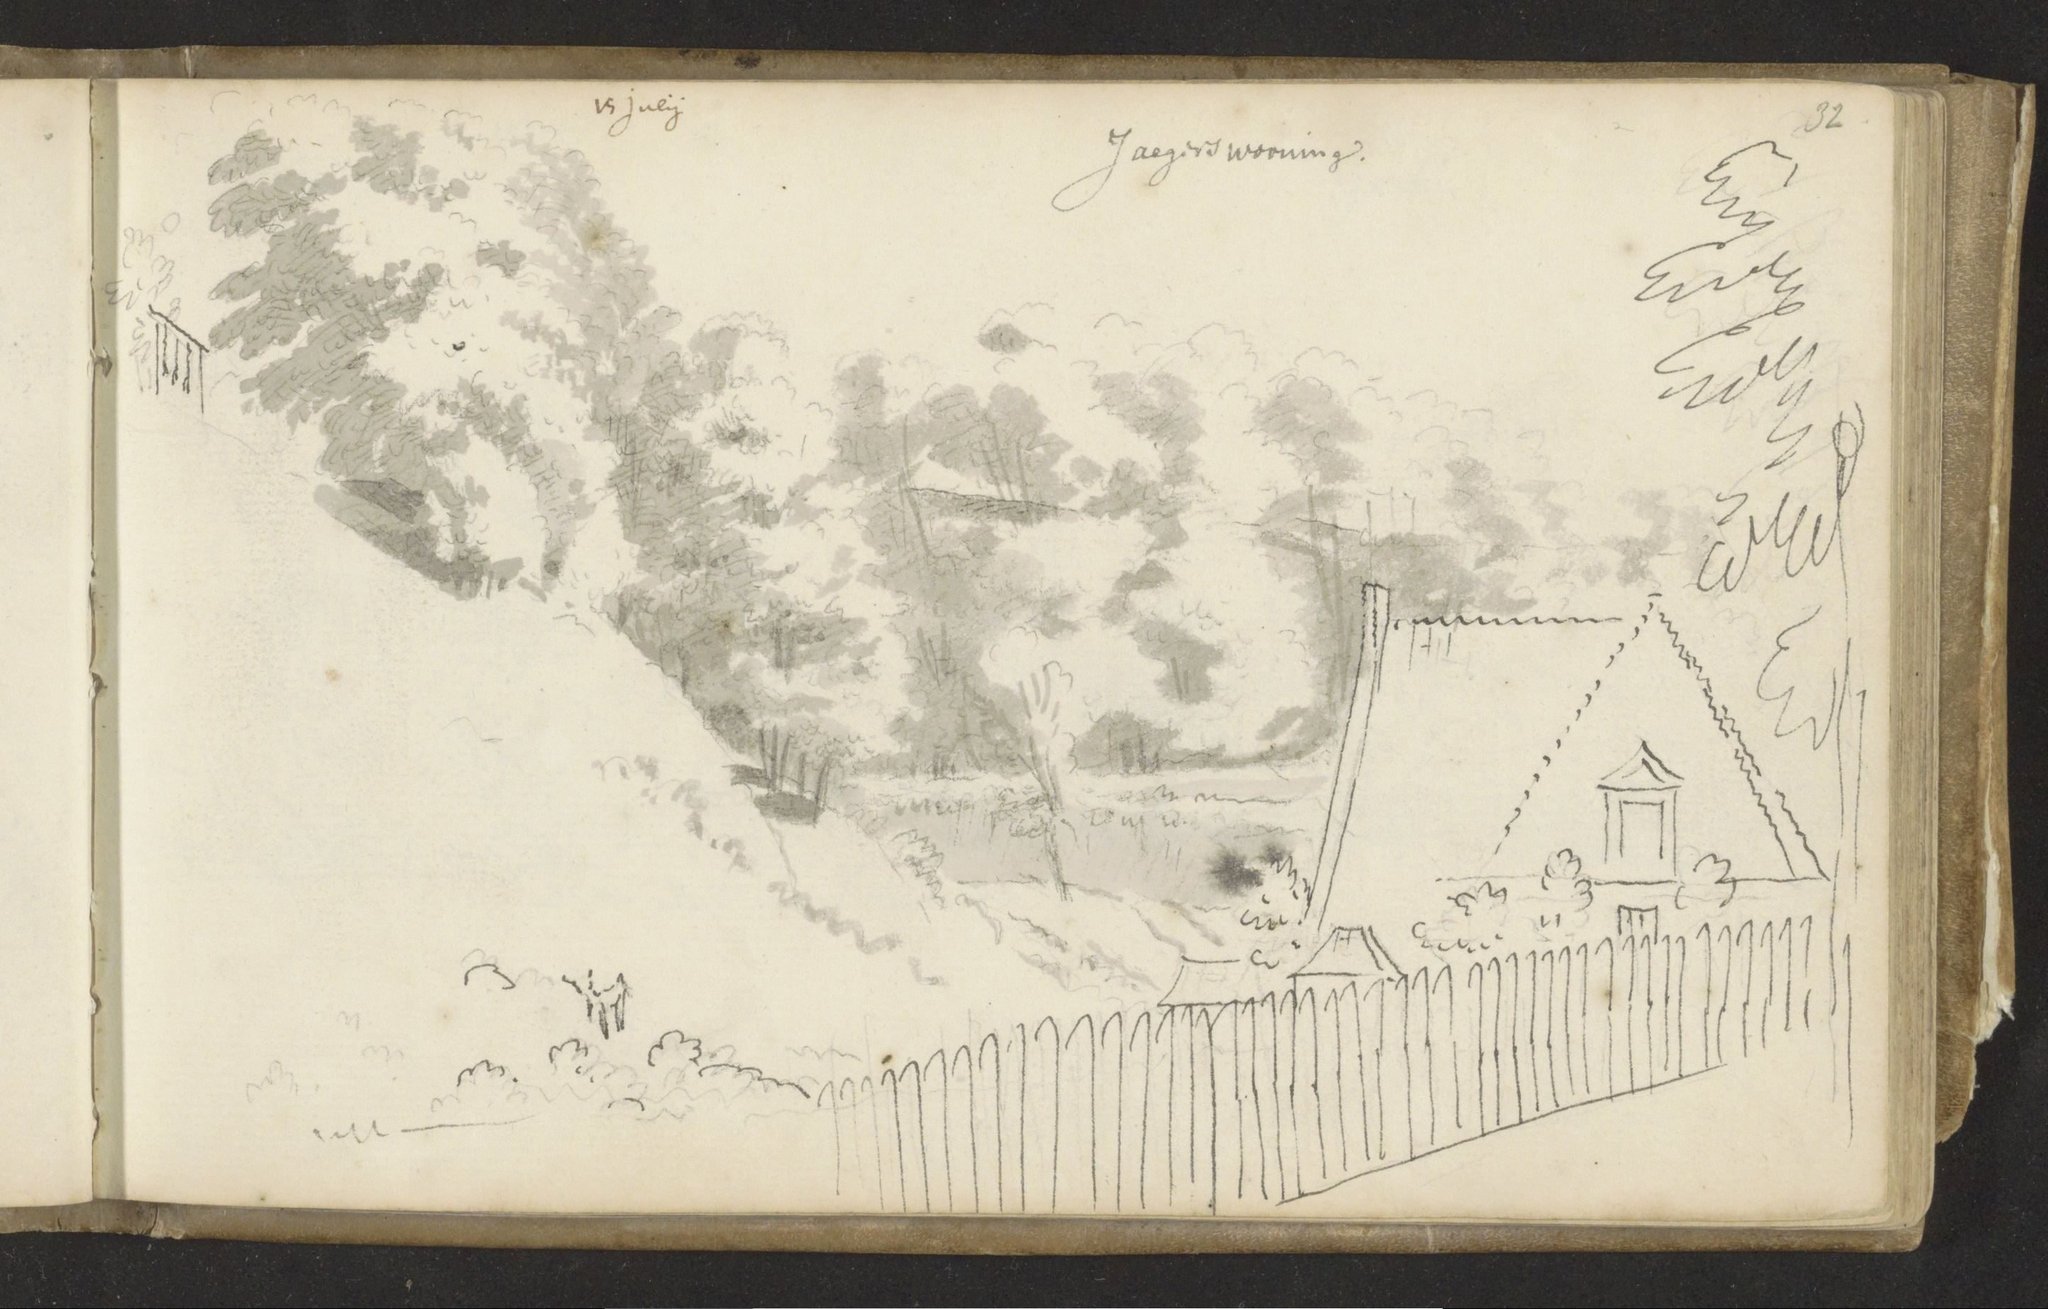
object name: sketchbook leaf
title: Bosrand met jagerswoning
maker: abraham de haen (ii)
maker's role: draughtsman, print maker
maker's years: 1707-1748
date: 1731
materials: ink, paper, pencil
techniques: brush, pen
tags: fringe, edge of the wood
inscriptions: date and inscription: ‘15 julij/ Jaegerswooning’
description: Blad 32 recto uit een schetsboek met 69 bladen.